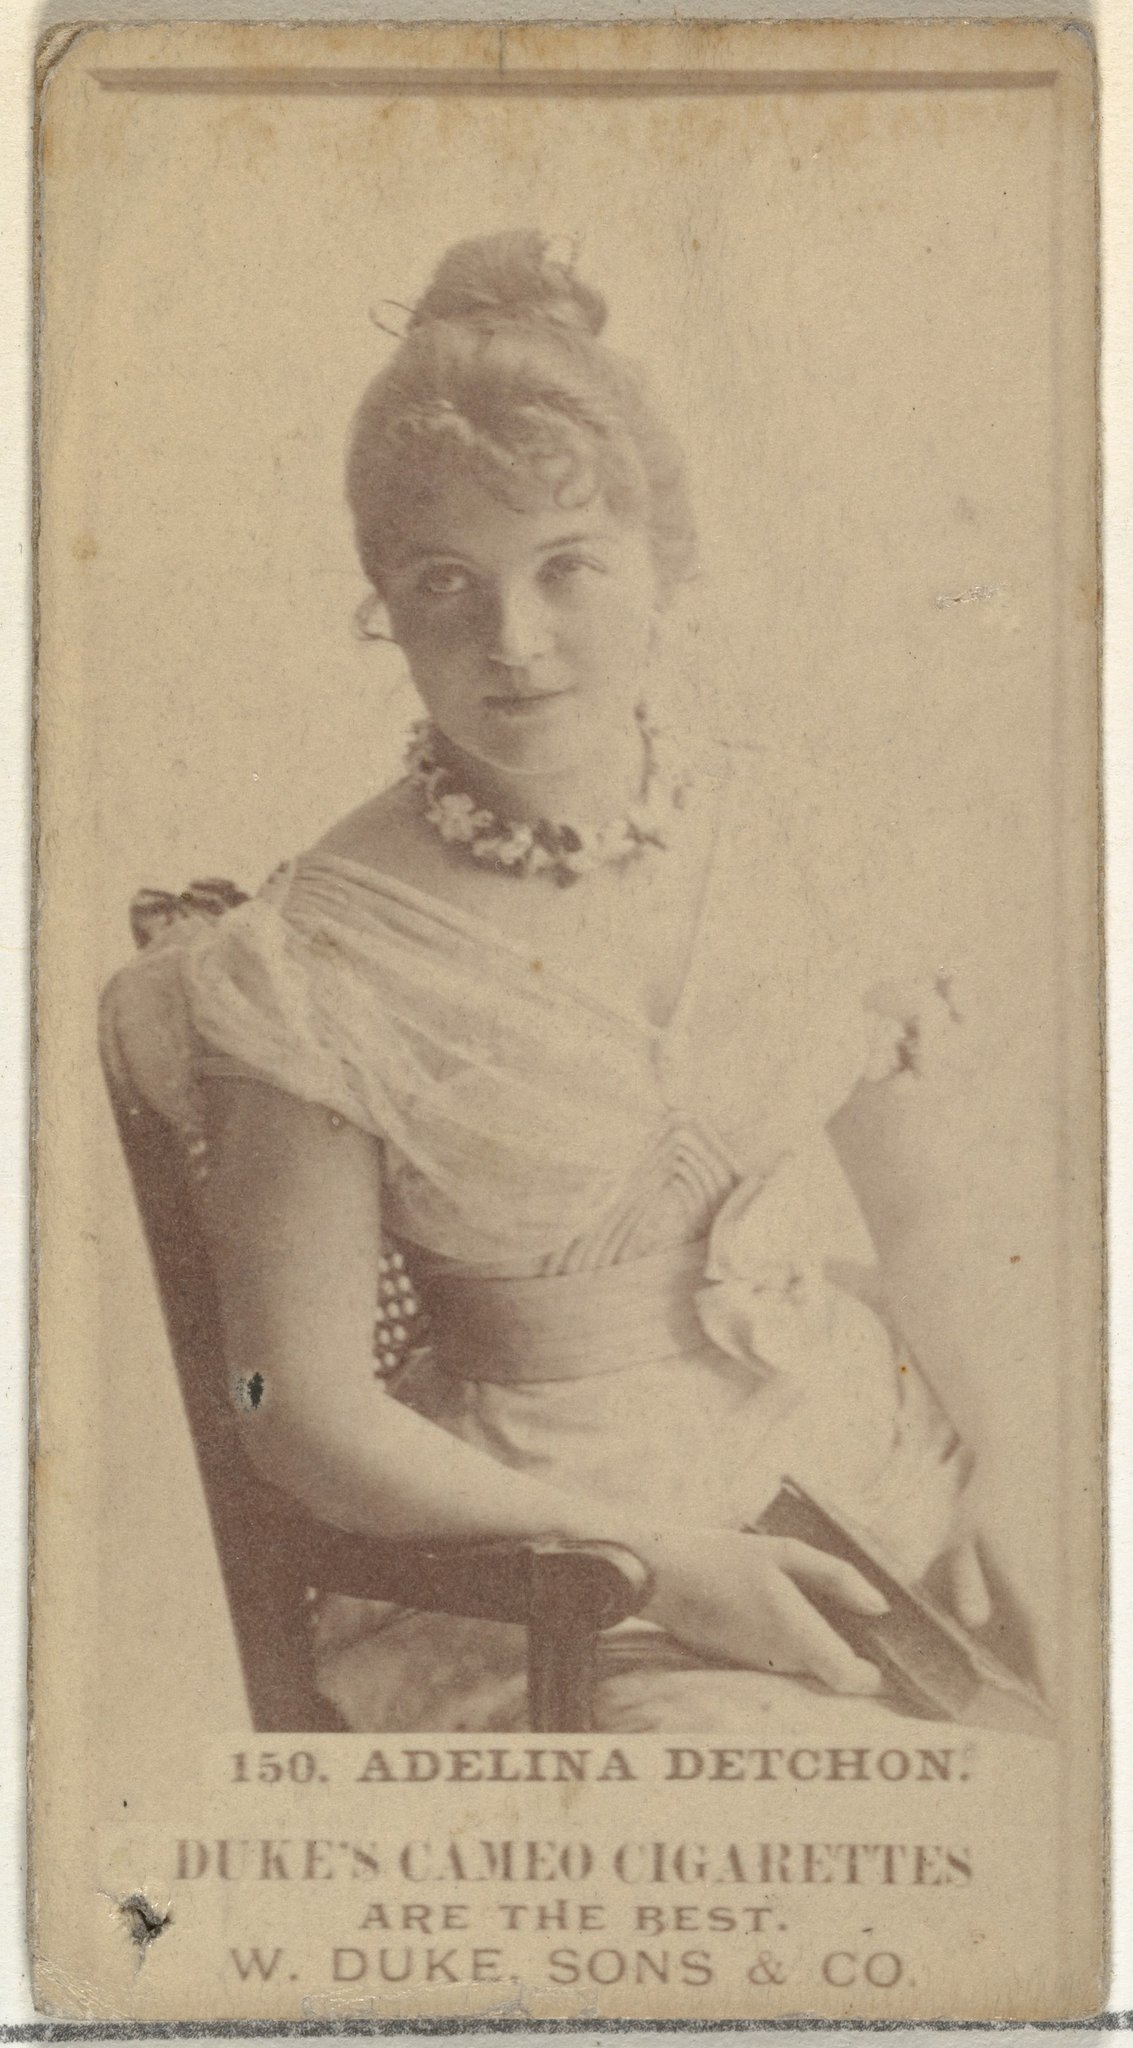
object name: photograph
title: Card Number 150, Adelina Detchon, from the Actors and Actresses series (N145-5) issued by Duke Sons & Co. to promote Cameo Cigarettes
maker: w. duke, sons & co.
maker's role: publisher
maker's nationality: american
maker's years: 1870-1920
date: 1880-1889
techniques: albumen silver print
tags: portraits,women,actresses